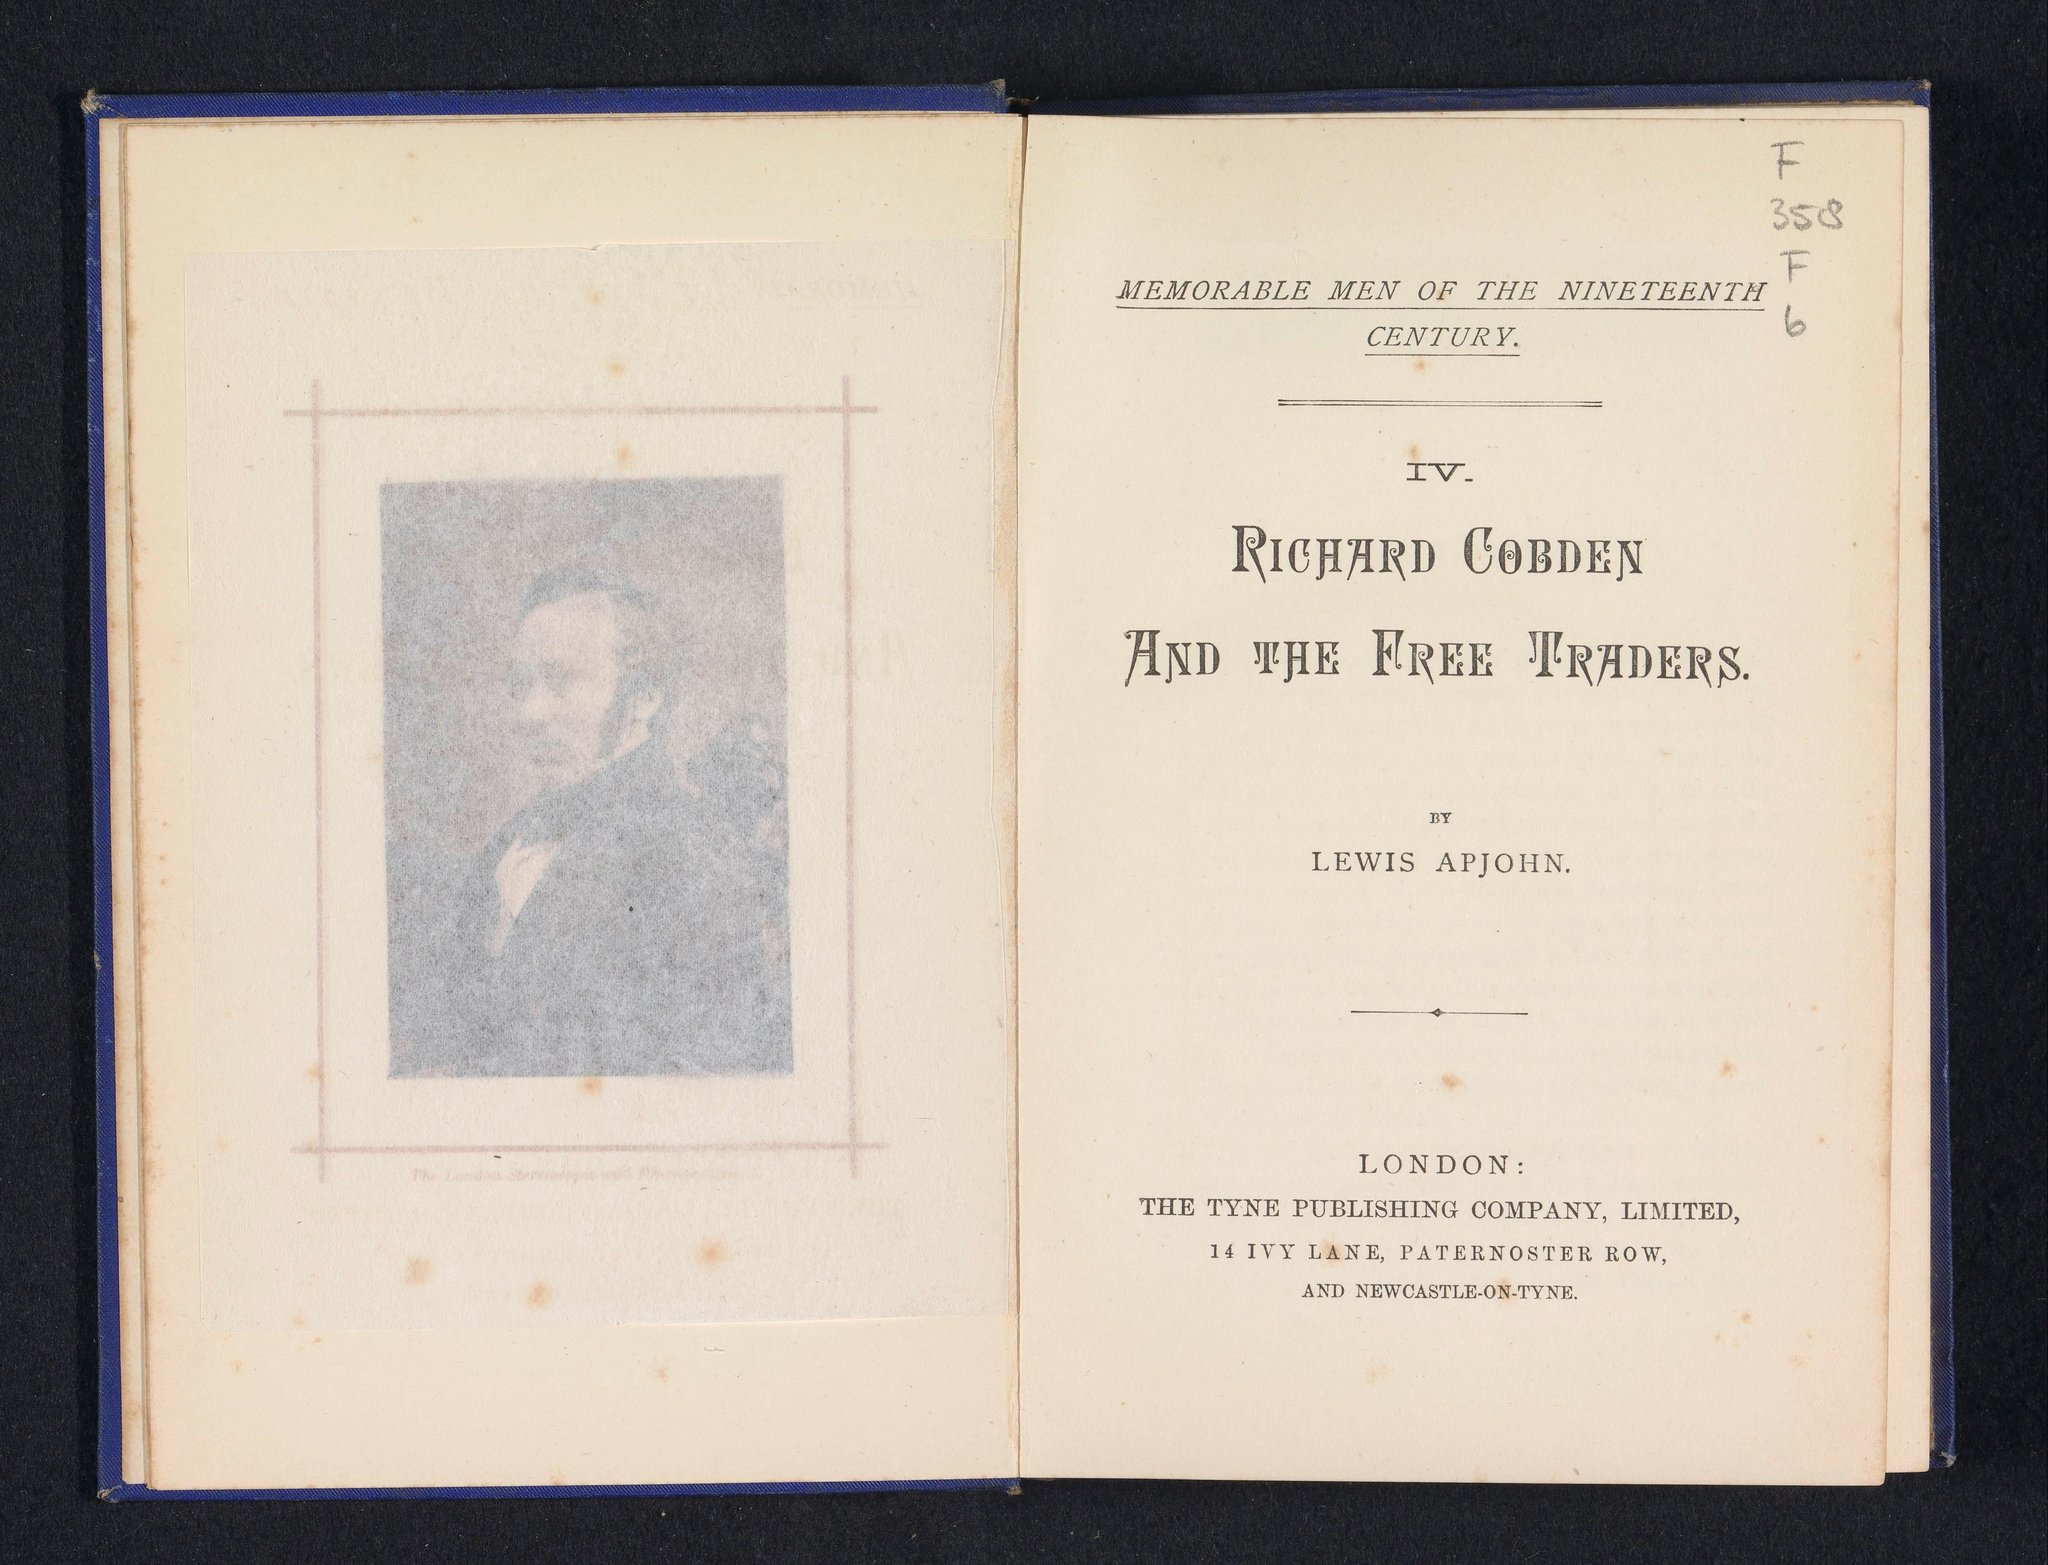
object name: book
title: Richard Cobden and the free traders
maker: lewis apjohn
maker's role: schrijver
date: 1885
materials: cardboard, linen, paper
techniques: woodburytype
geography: london